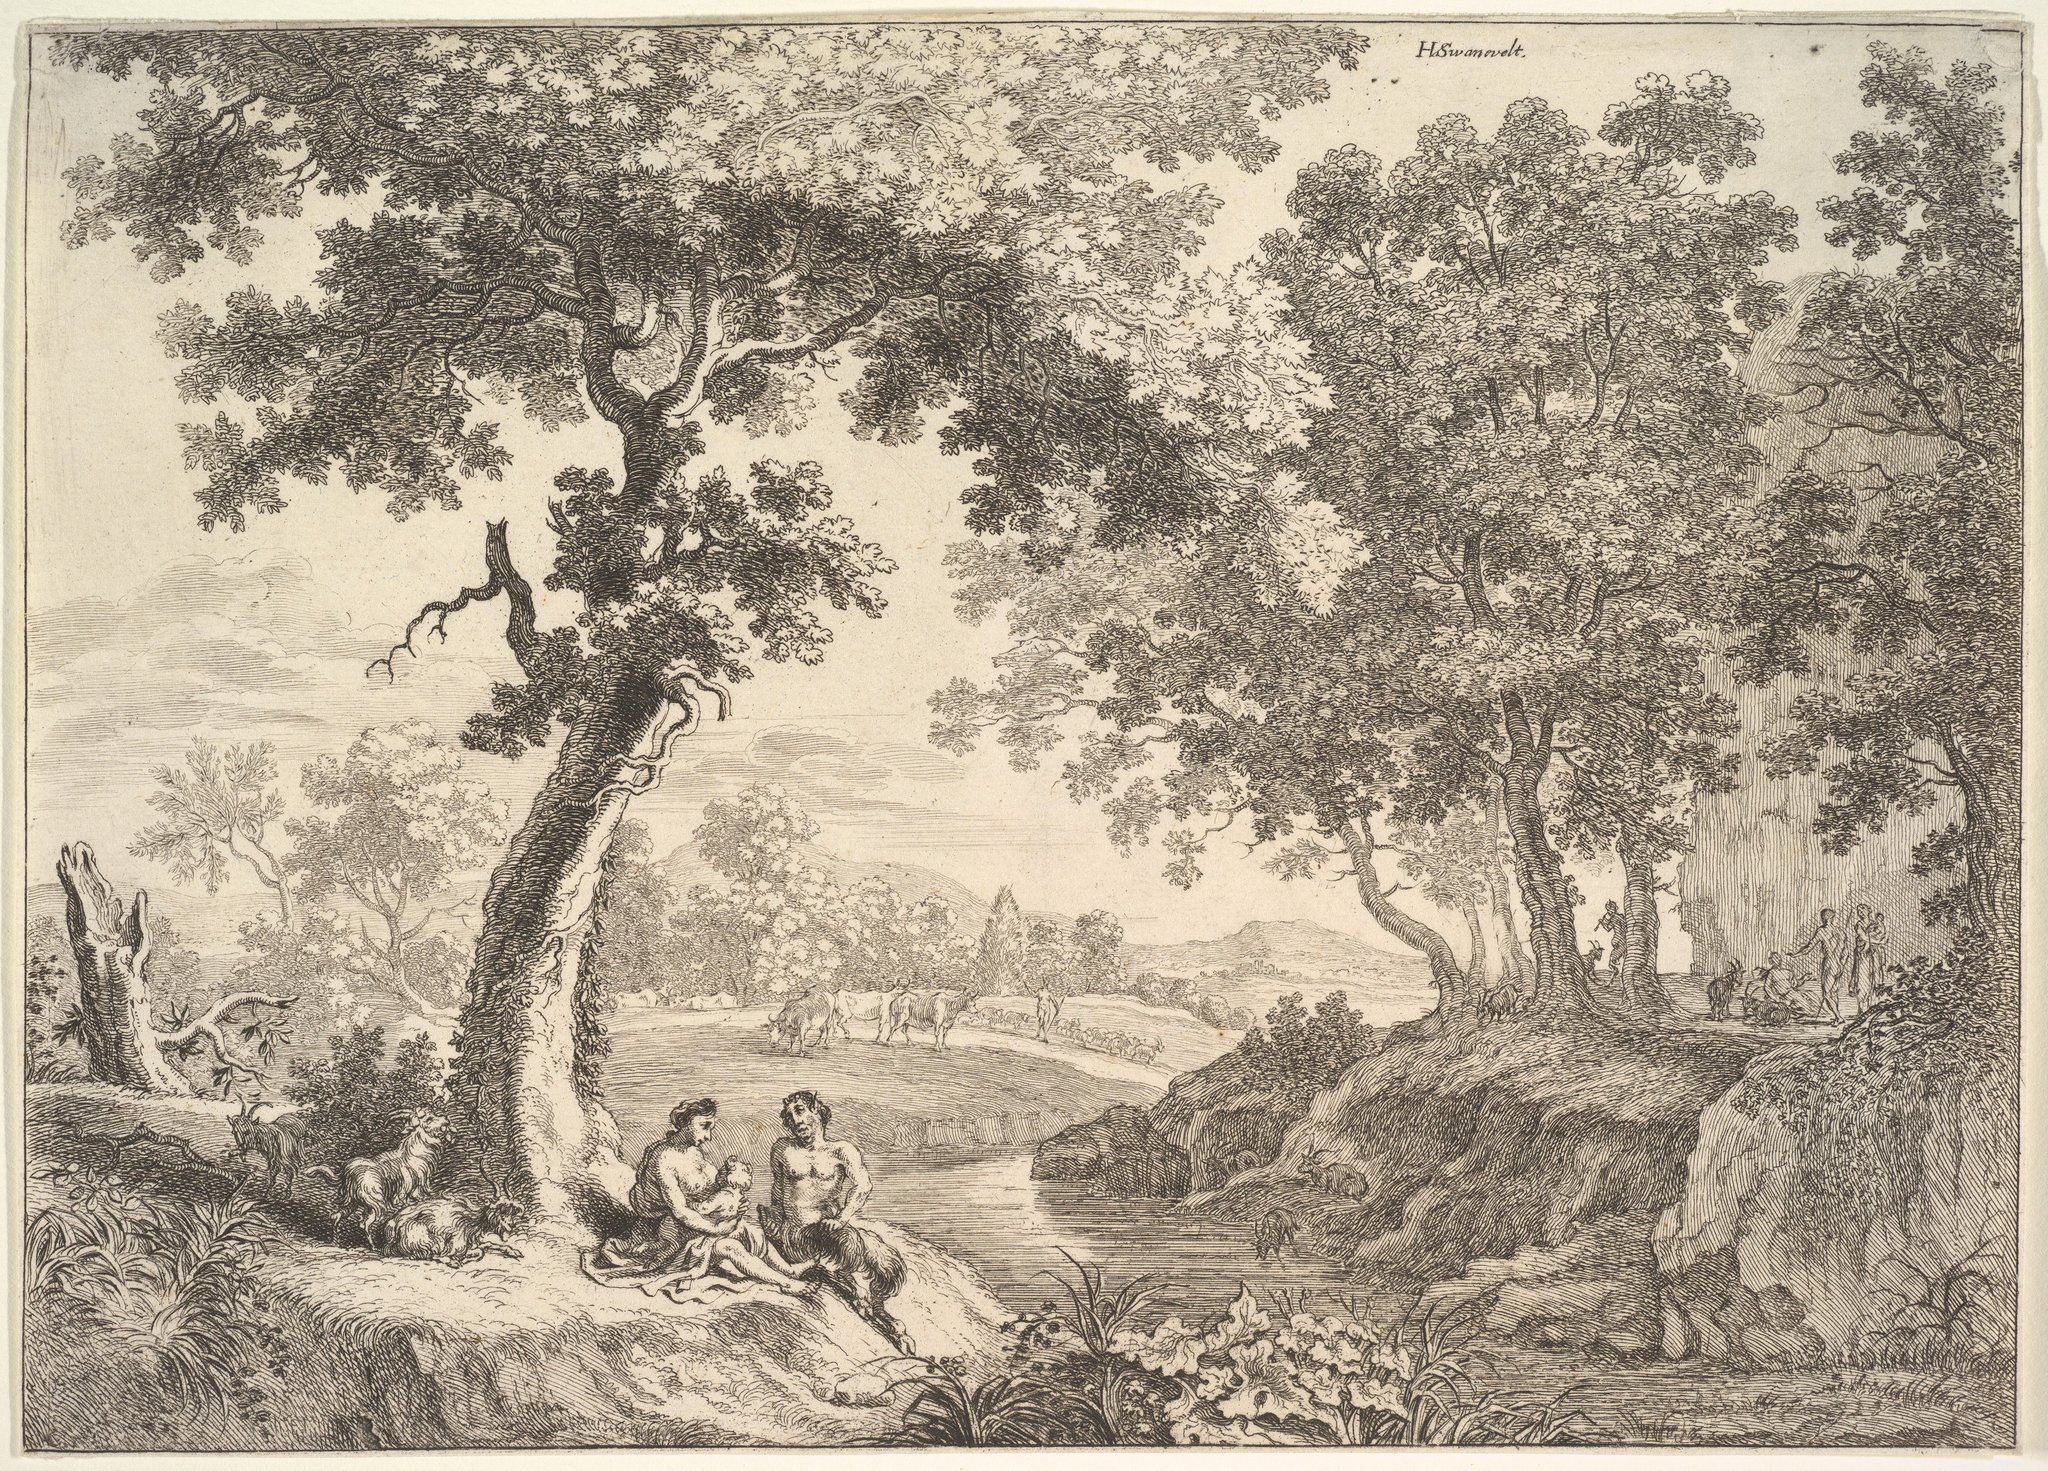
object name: print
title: Satyrs in a Landscape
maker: Anonymous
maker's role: artist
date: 1600-1800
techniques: etching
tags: satyrs,landscapes,trees